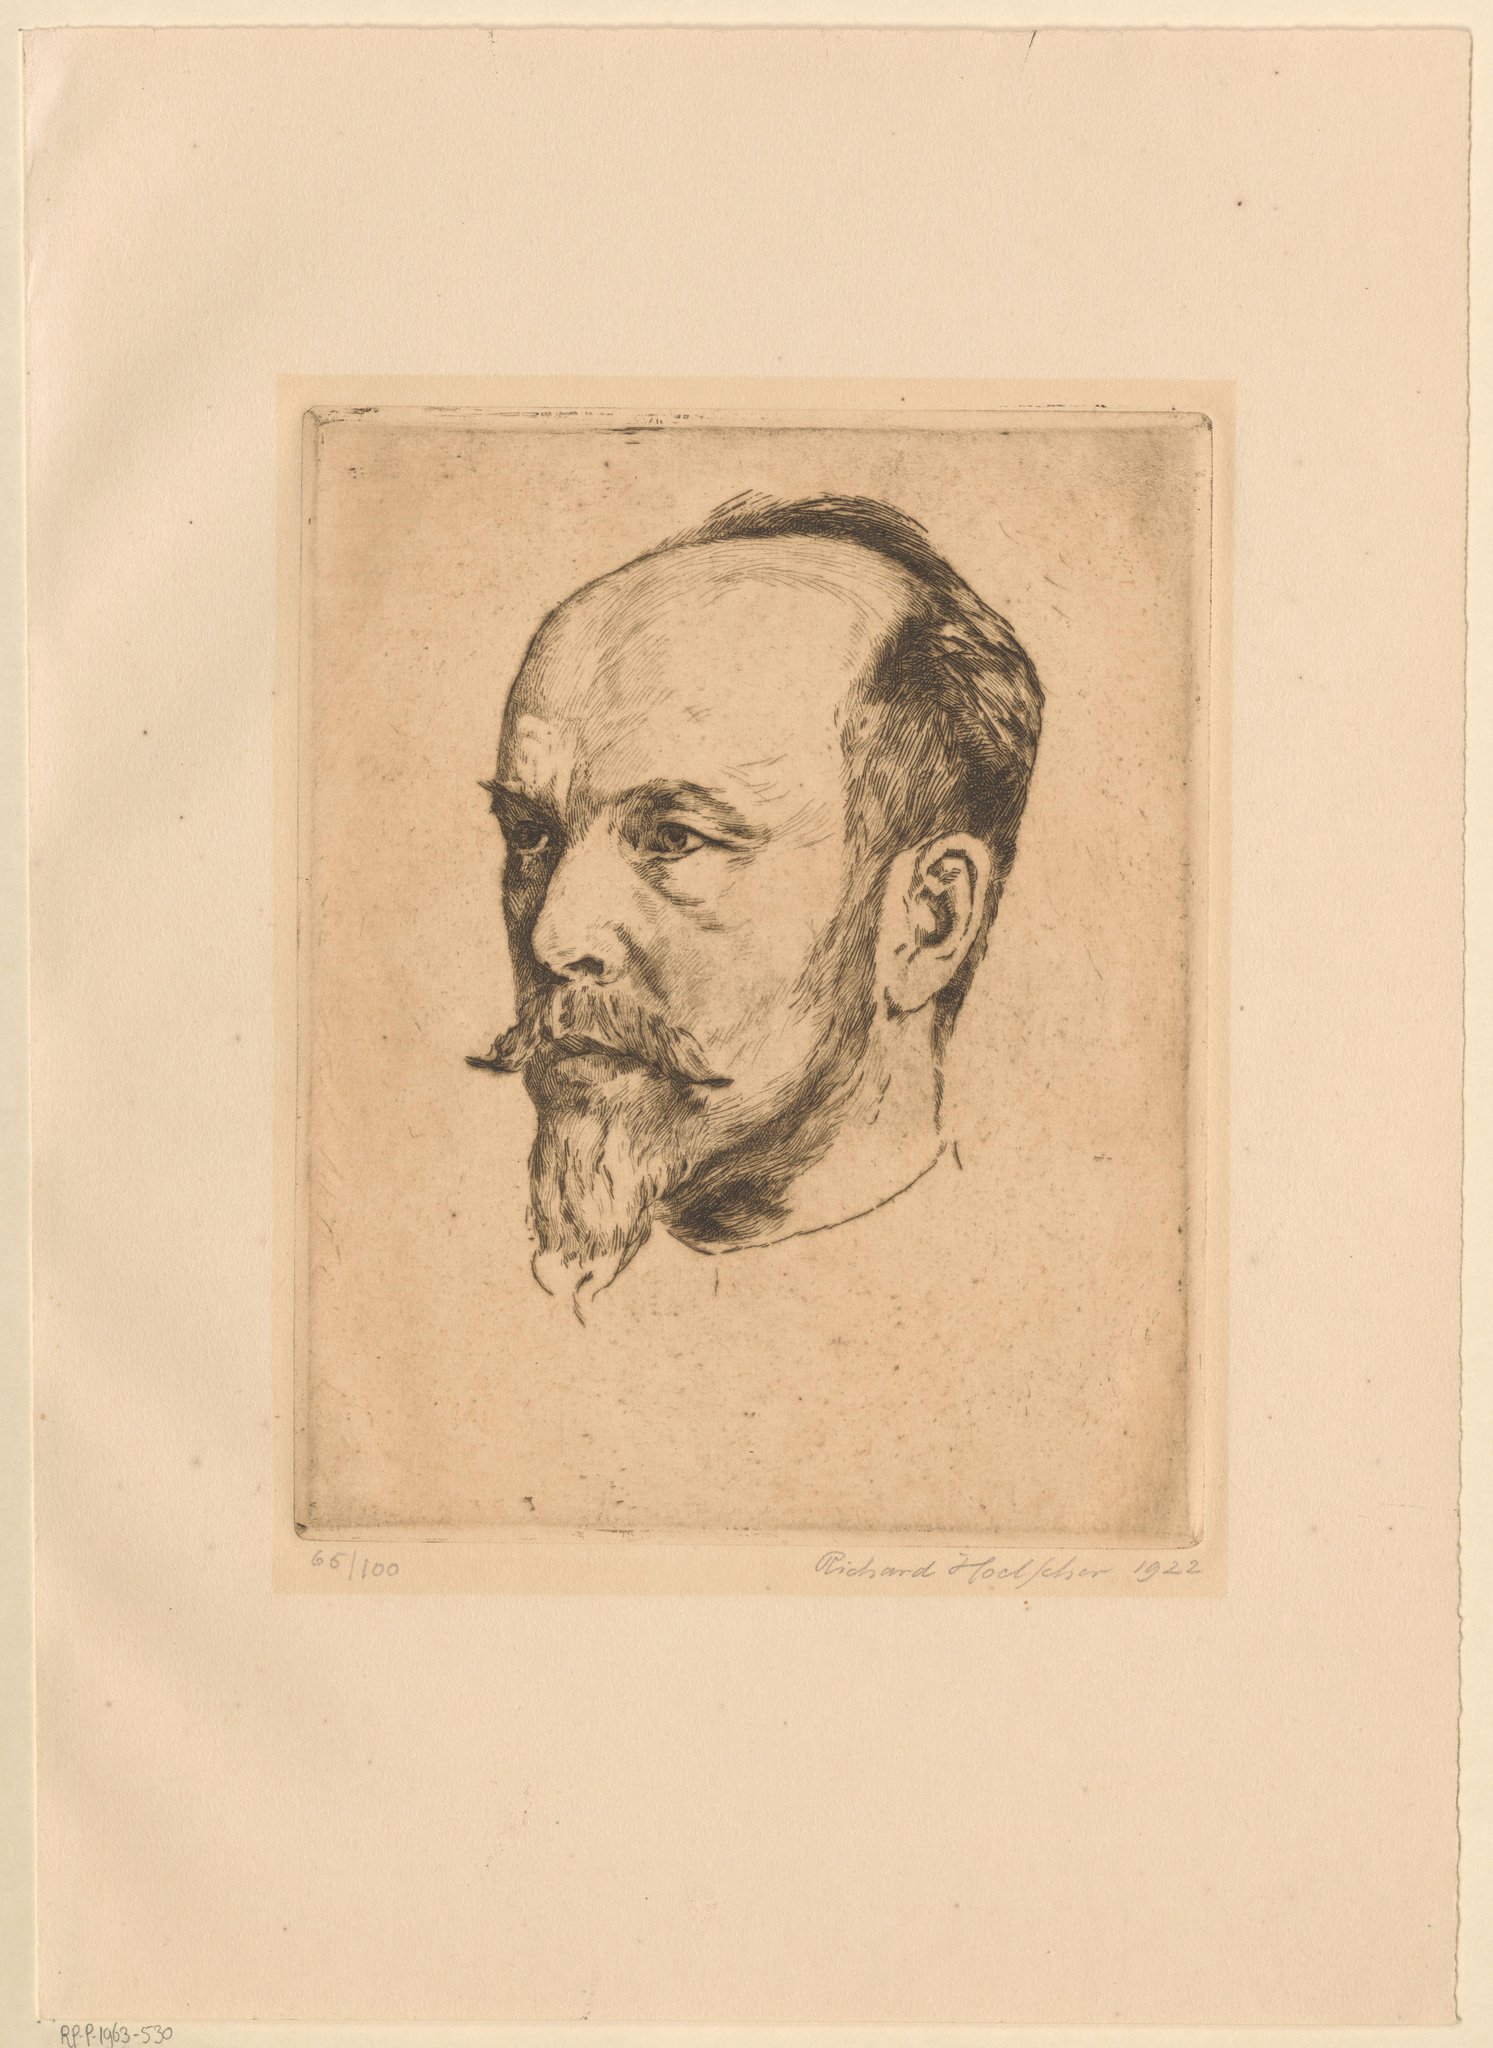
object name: print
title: Portret van Hermann von Keyserling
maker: richard hoelscher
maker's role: painter, print maker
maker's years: 1867-1943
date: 1922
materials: paper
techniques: etching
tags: historical persons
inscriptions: collector's mark: Lugt 2228